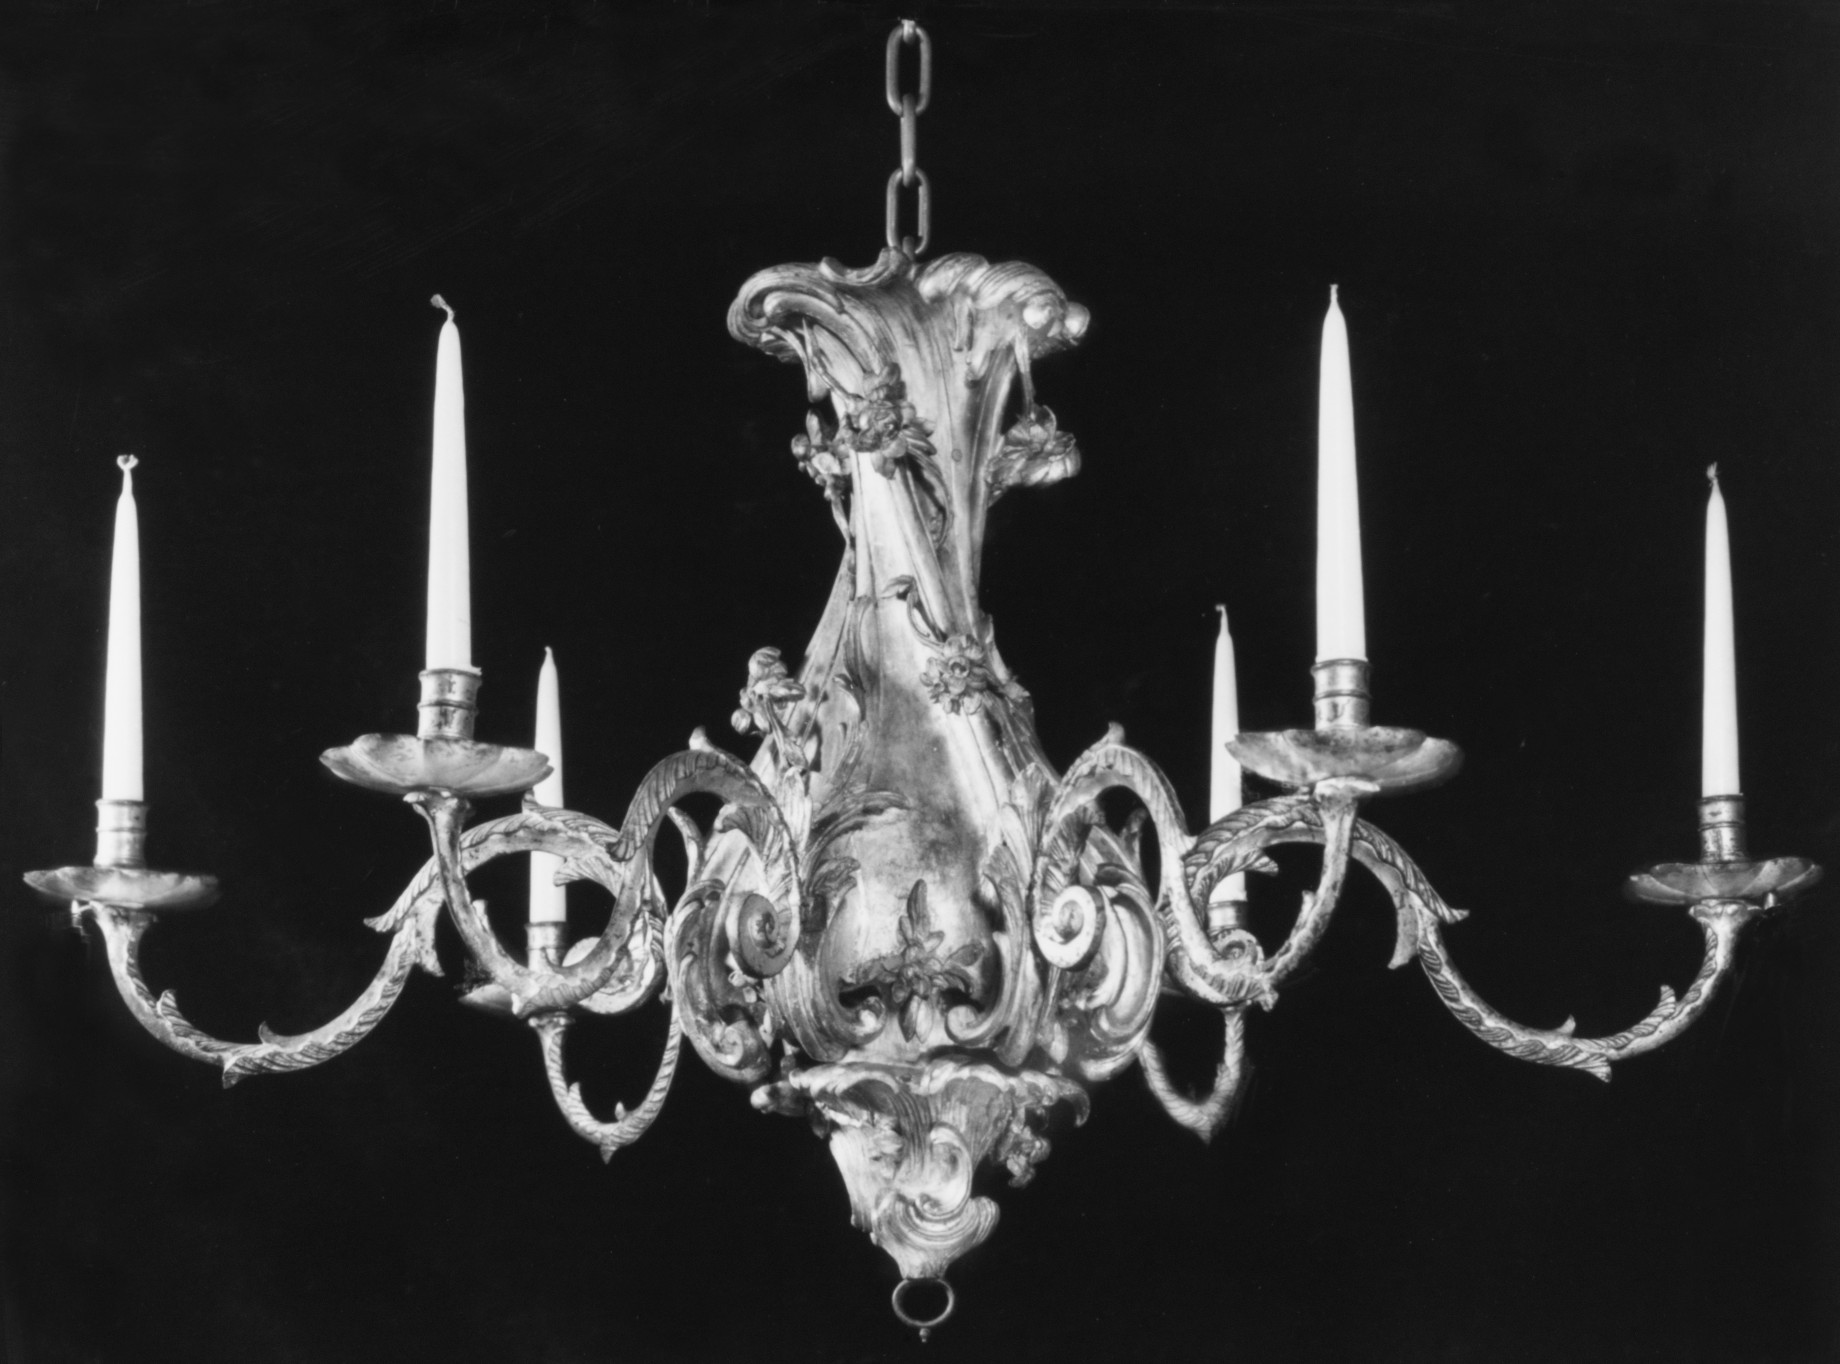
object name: chandelier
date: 1765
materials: gilt, metal, wood